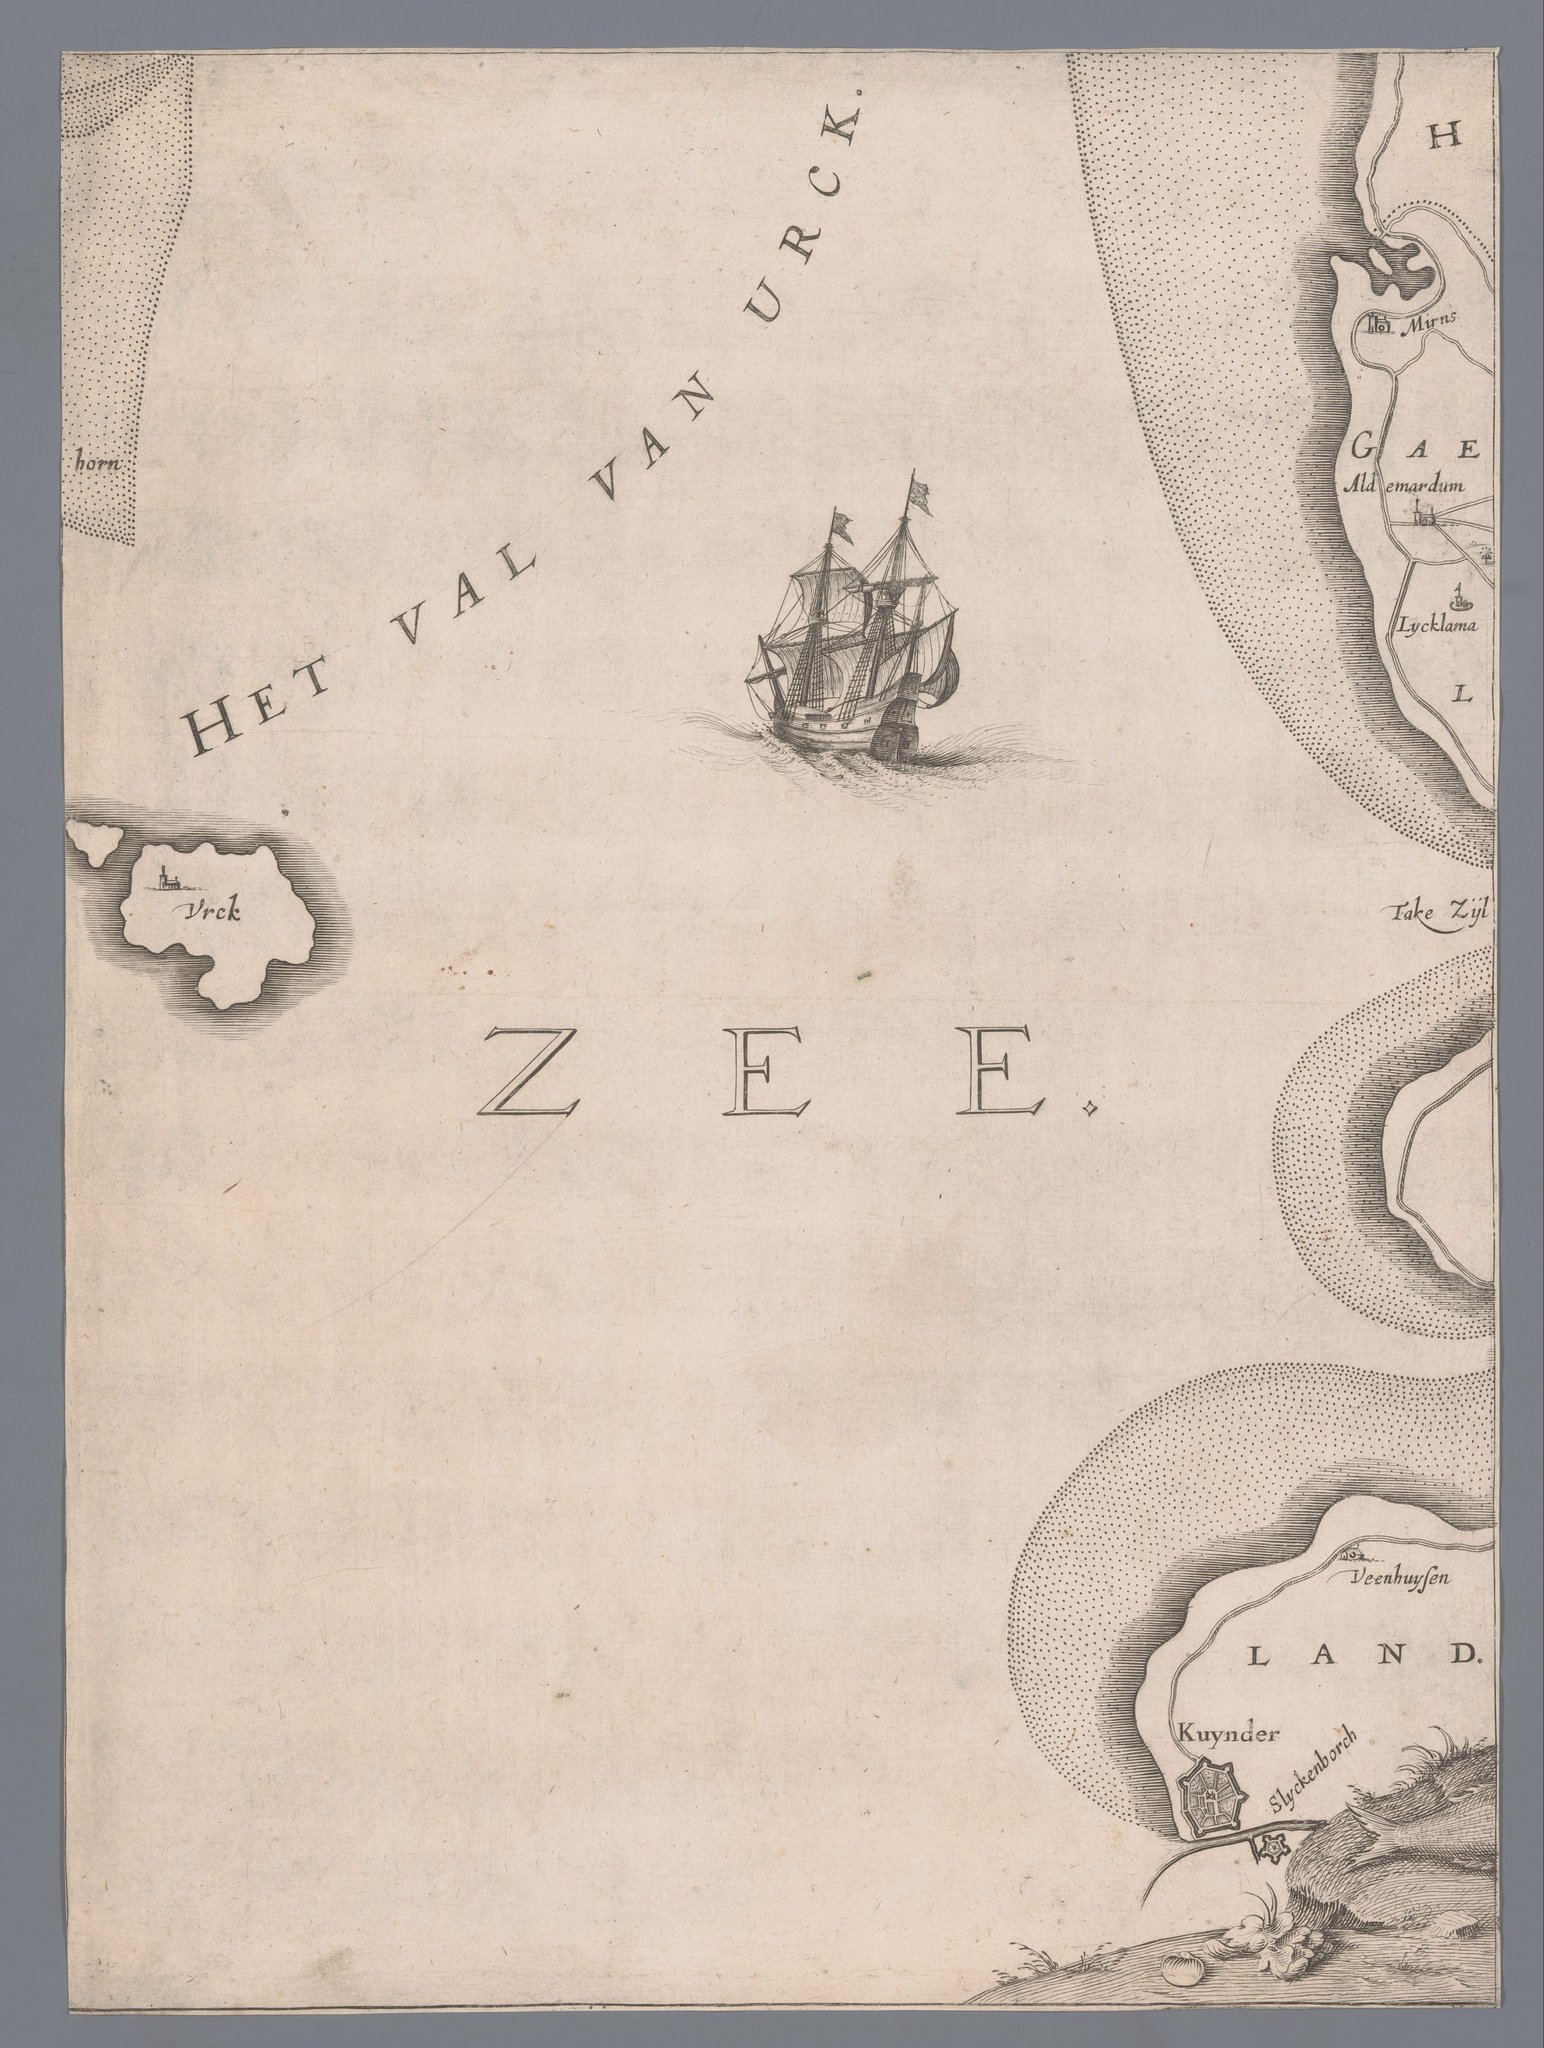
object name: print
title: Kaart van het Graafschap Holland en Utrecht (plaat 38)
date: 1639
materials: paper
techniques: engraving, etching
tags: sailing-ship, sailing-boat, maps, atlases, zuiderzee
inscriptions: collector's mark: Lugt 2228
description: Onderdeel van een kaart samengesteld uit 40 bladen. Waarschijnlijk gaat het om de grootste kaart van Holland uit de zeventiende-eeuw. De kaart is uitgegeven in verschillende edities, deze kaart uit 1639 is de eerste editie.